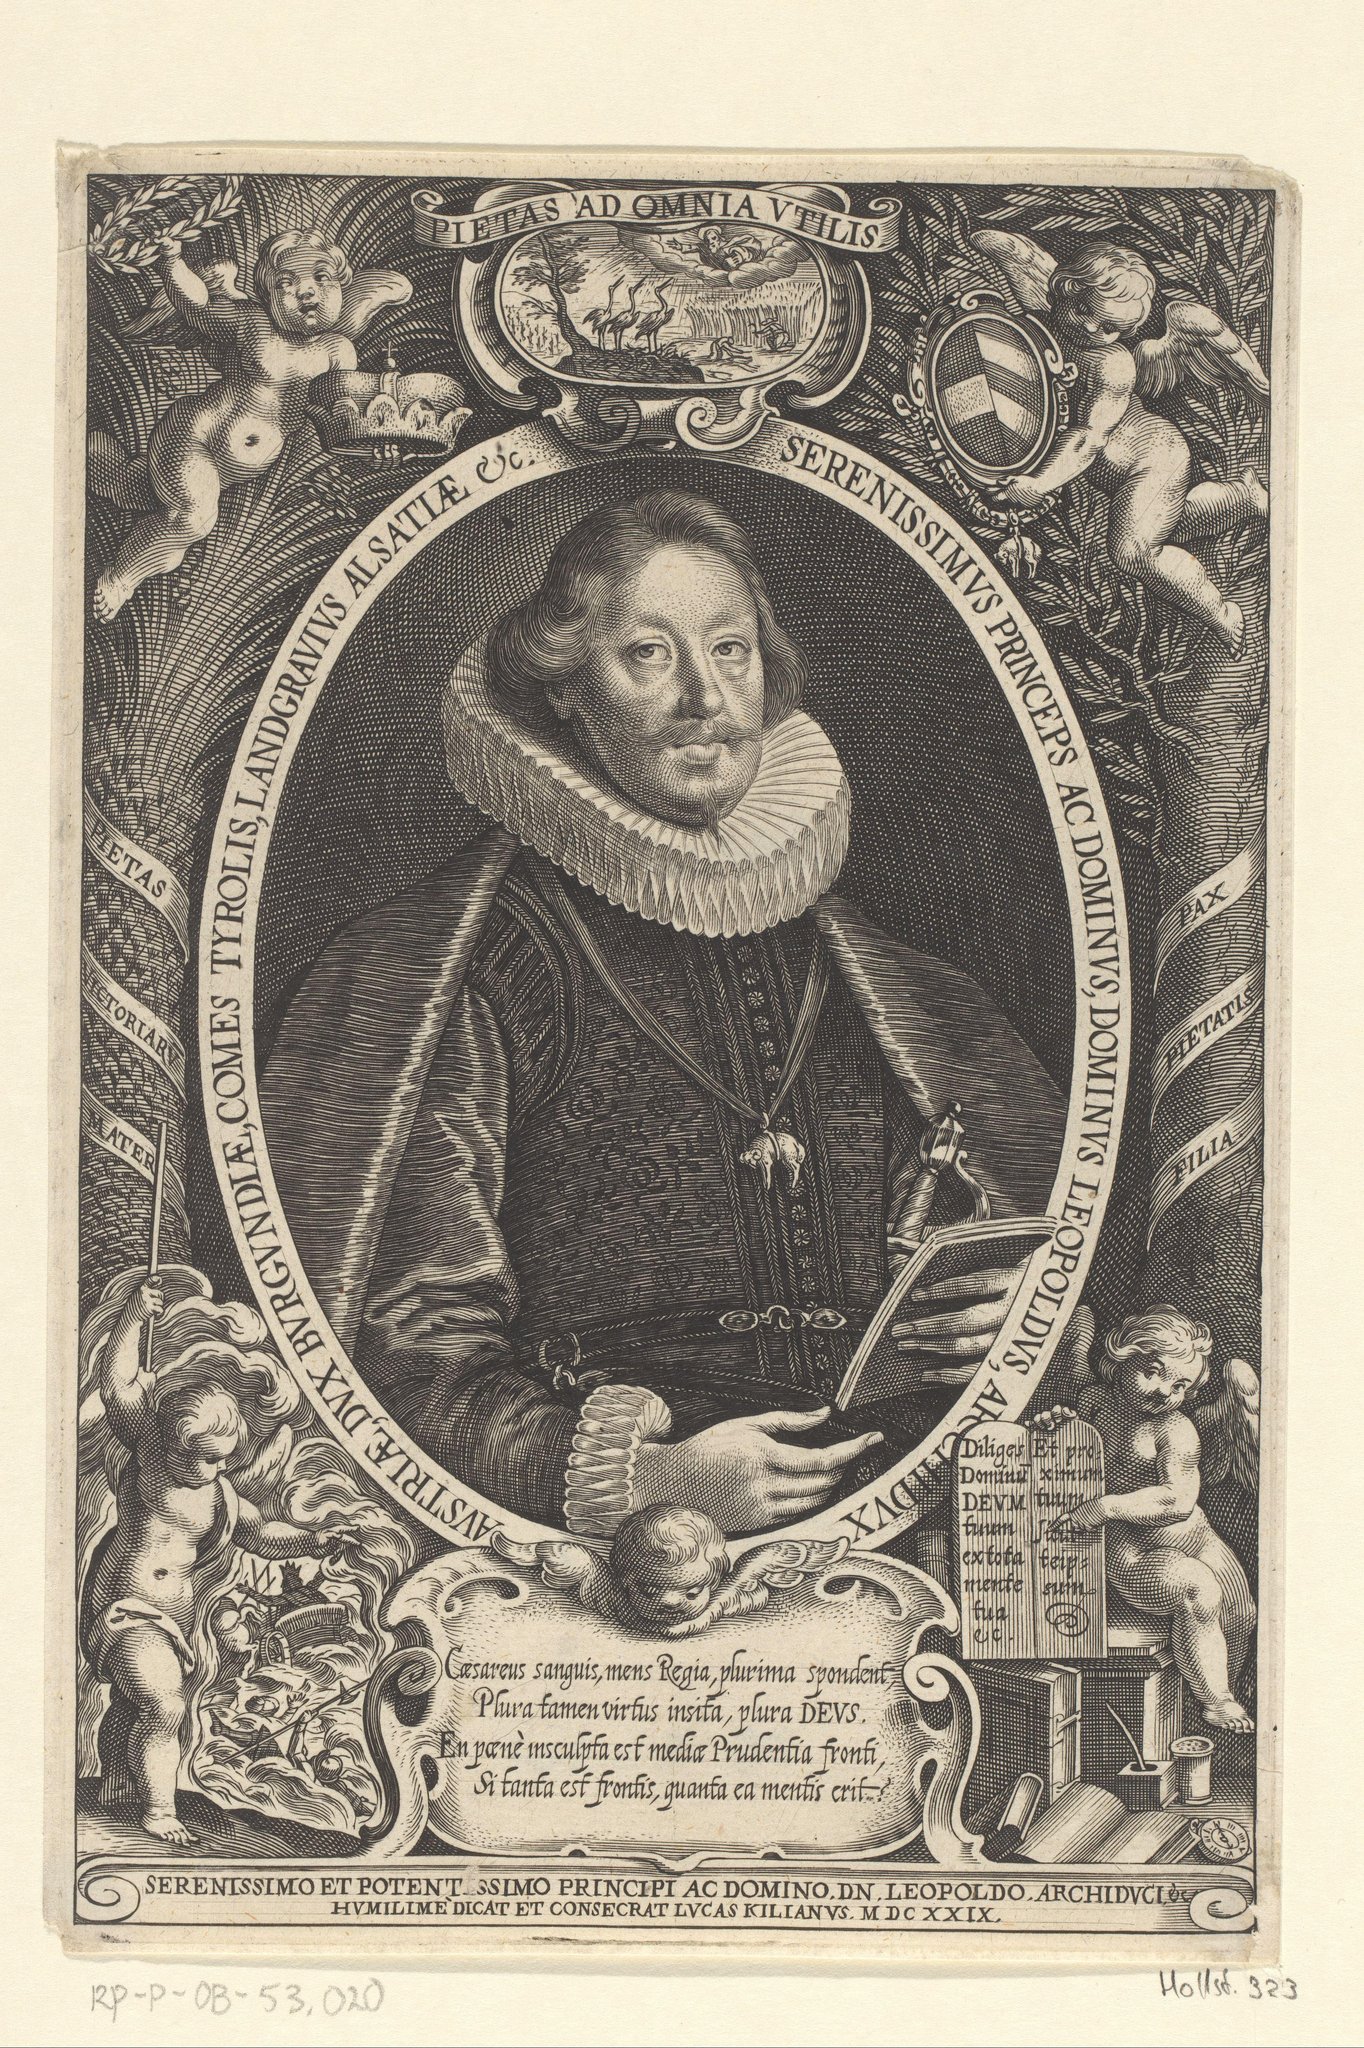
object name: print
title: Portret van Leopold V, aartshertog van Oostenrijk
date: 1629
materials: paper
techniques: engraving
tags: leopold v (aartshertog van oostenrijk), historical persons, ruler, sovereign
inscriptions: date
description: Vier putti met symbolen van heerschappij in de hoeken. Tekst in het Latijn in de omlijsting, op de tafelen, de banier en in de ondermarge.